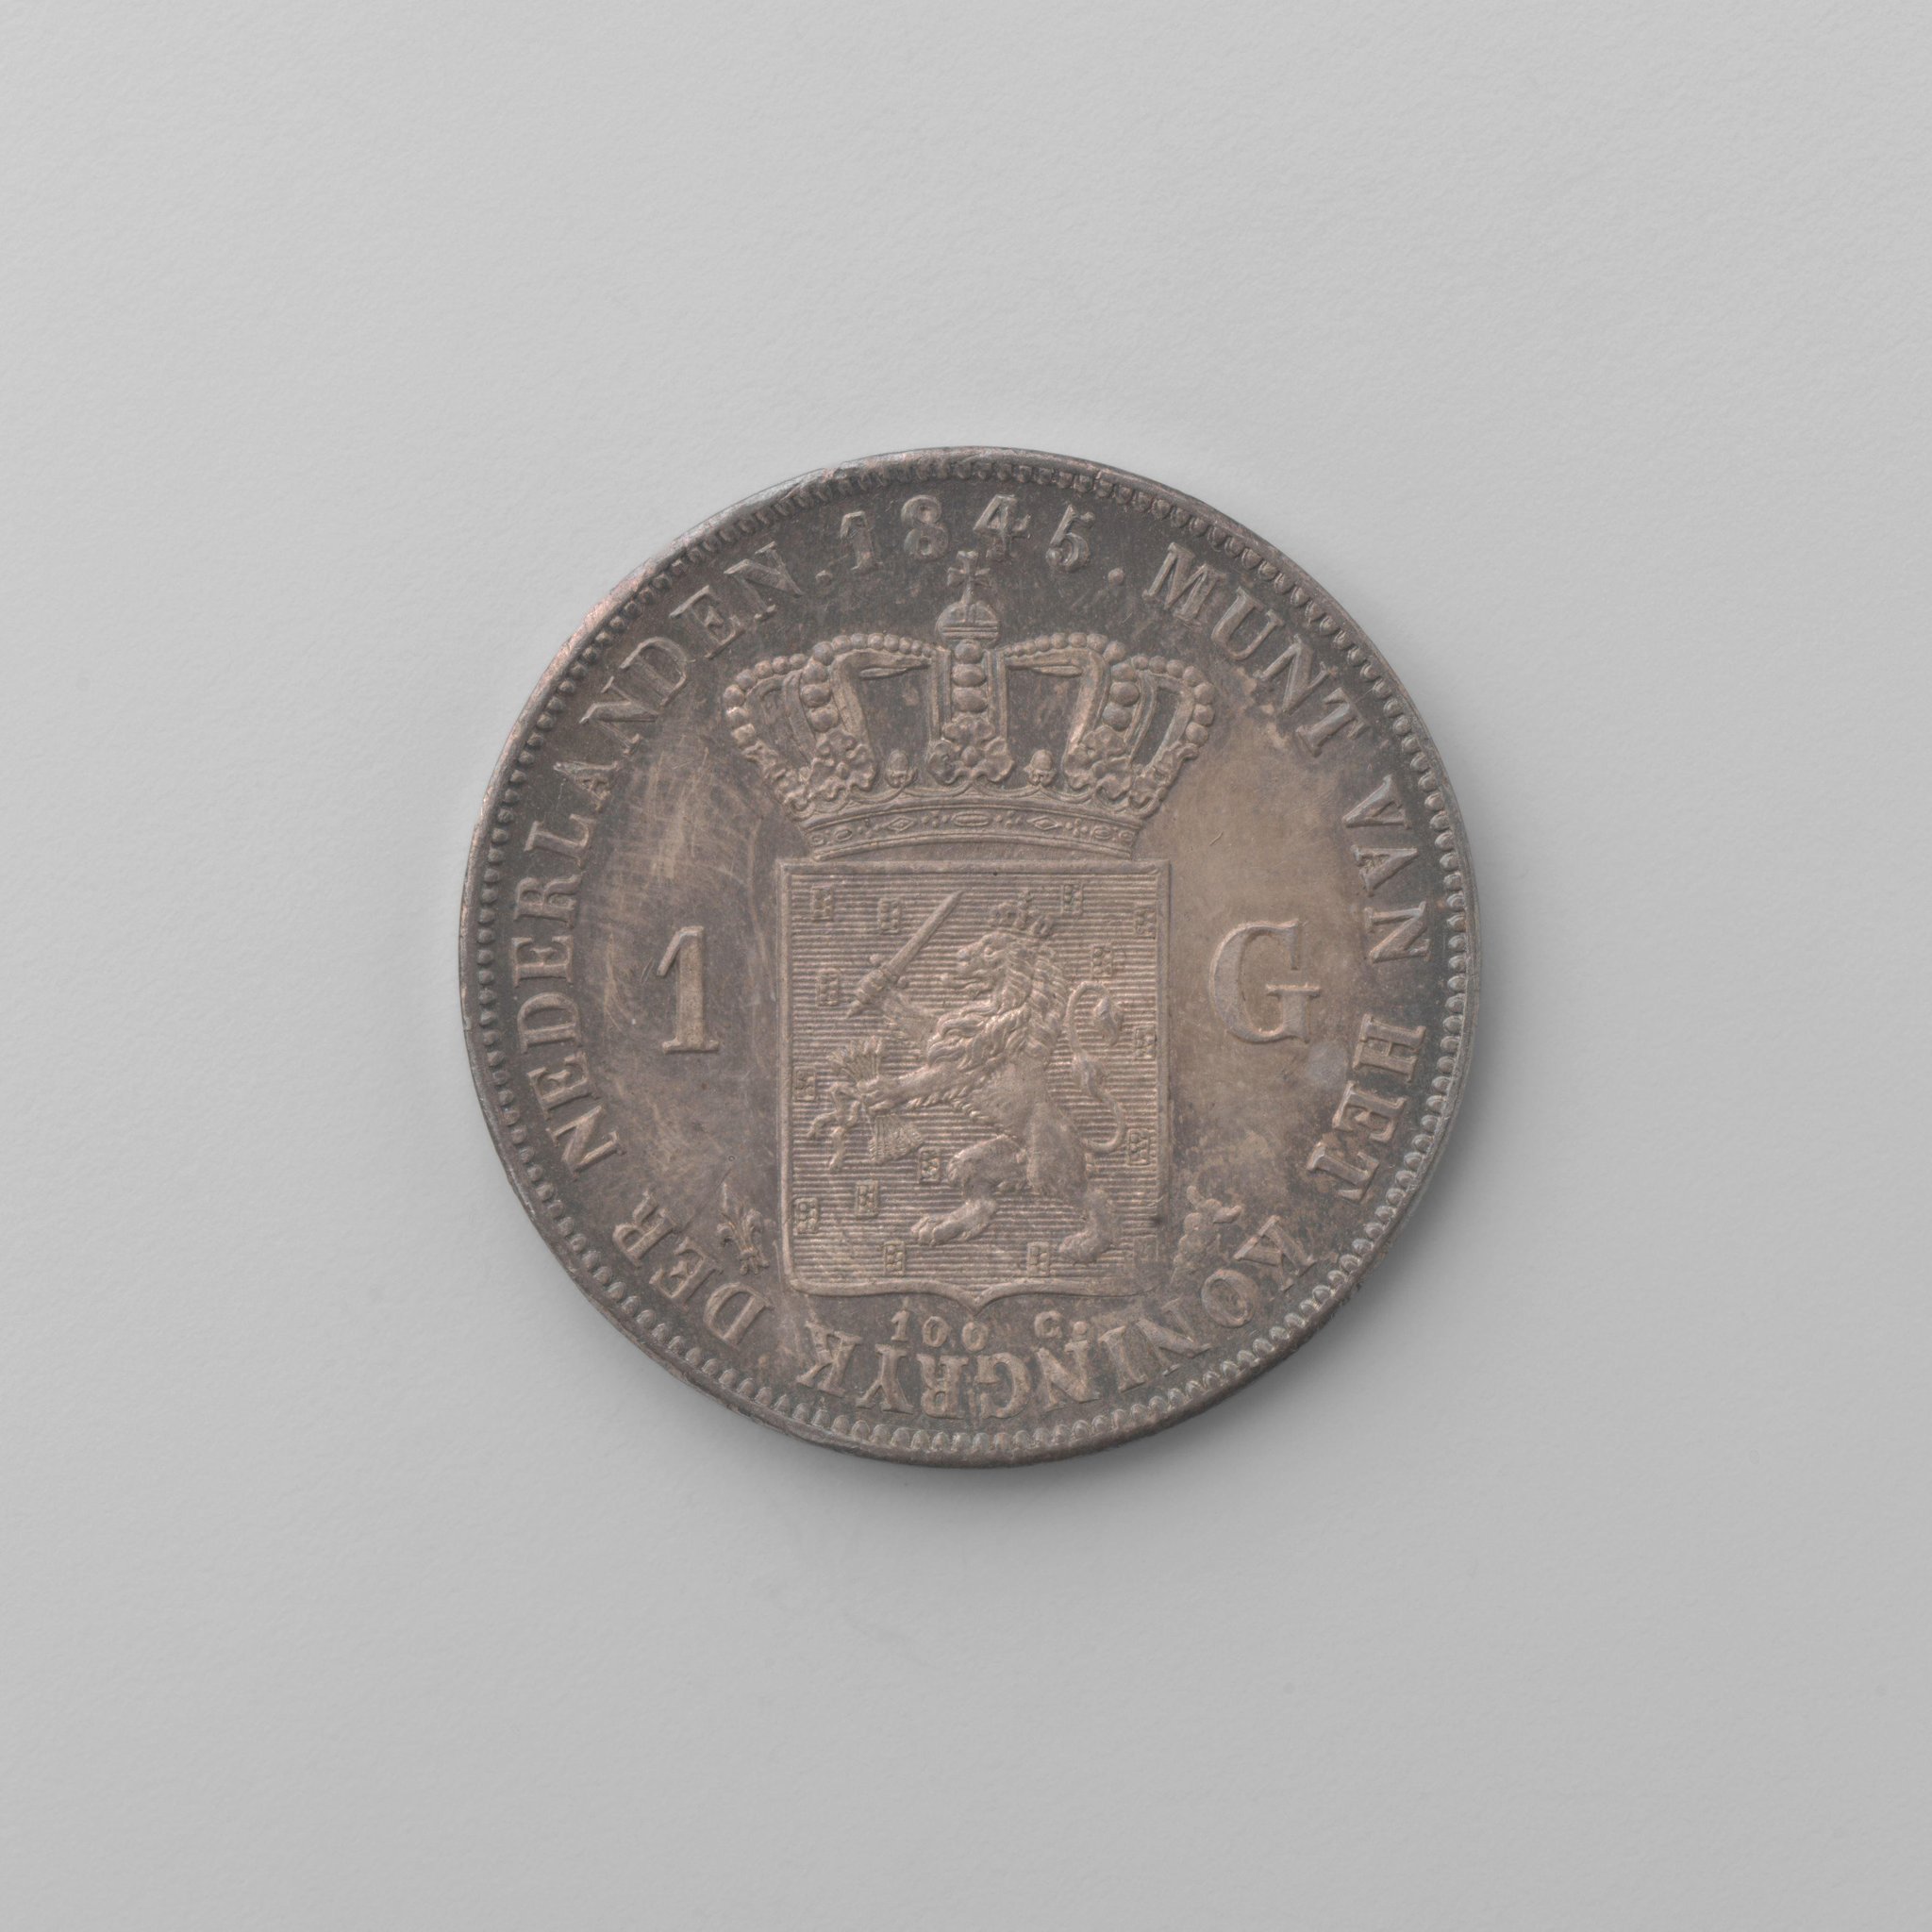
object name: coin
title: Nederland, gulden, 1845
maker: william ii of the netherlands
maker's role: koning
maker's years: 1792-1849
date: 1845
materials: silver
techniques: striking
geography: utrecht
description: Zilveren munt. Voorzijde: borstbeeld naar links. Keerzijde: tussen waarde-aanduiding 1 G gekroond rijkswapenschild. Jaartal boven kroon. Randschrift.